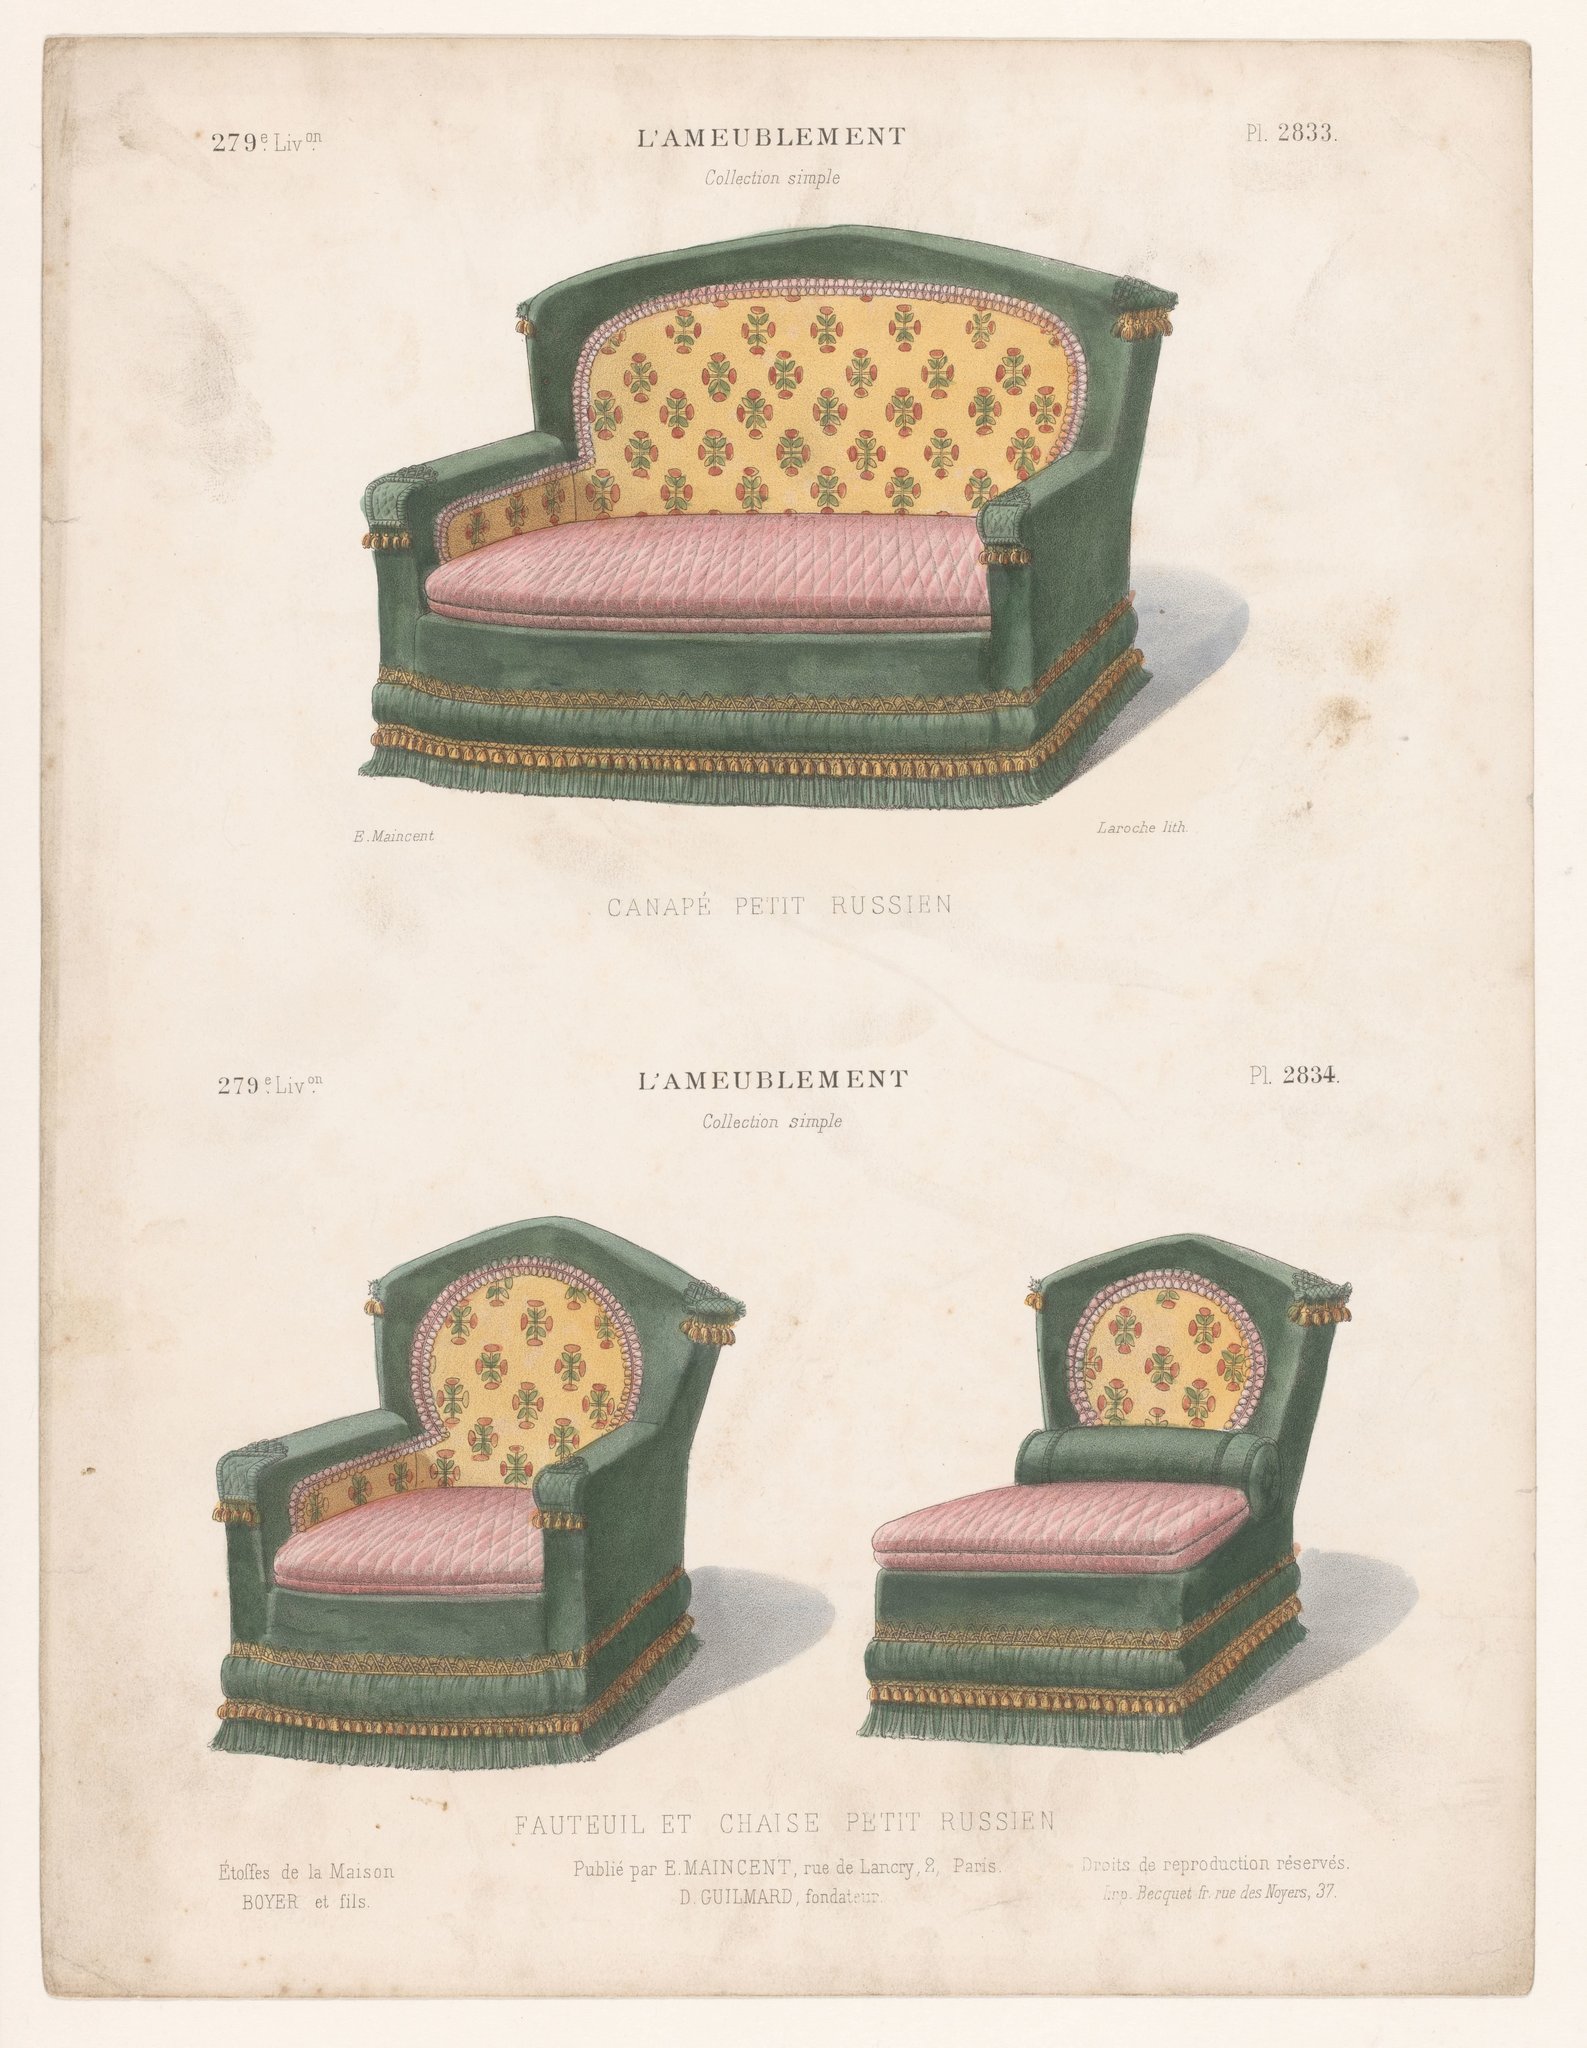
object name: print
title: L'ameublement / Collection simple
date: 1885-1895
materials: paper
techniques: hand coloring, lithograph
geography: paris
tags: shelves, rack, sideboard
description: Een canapé, fauteuil en stoel. Prent uit 279e Livraison.